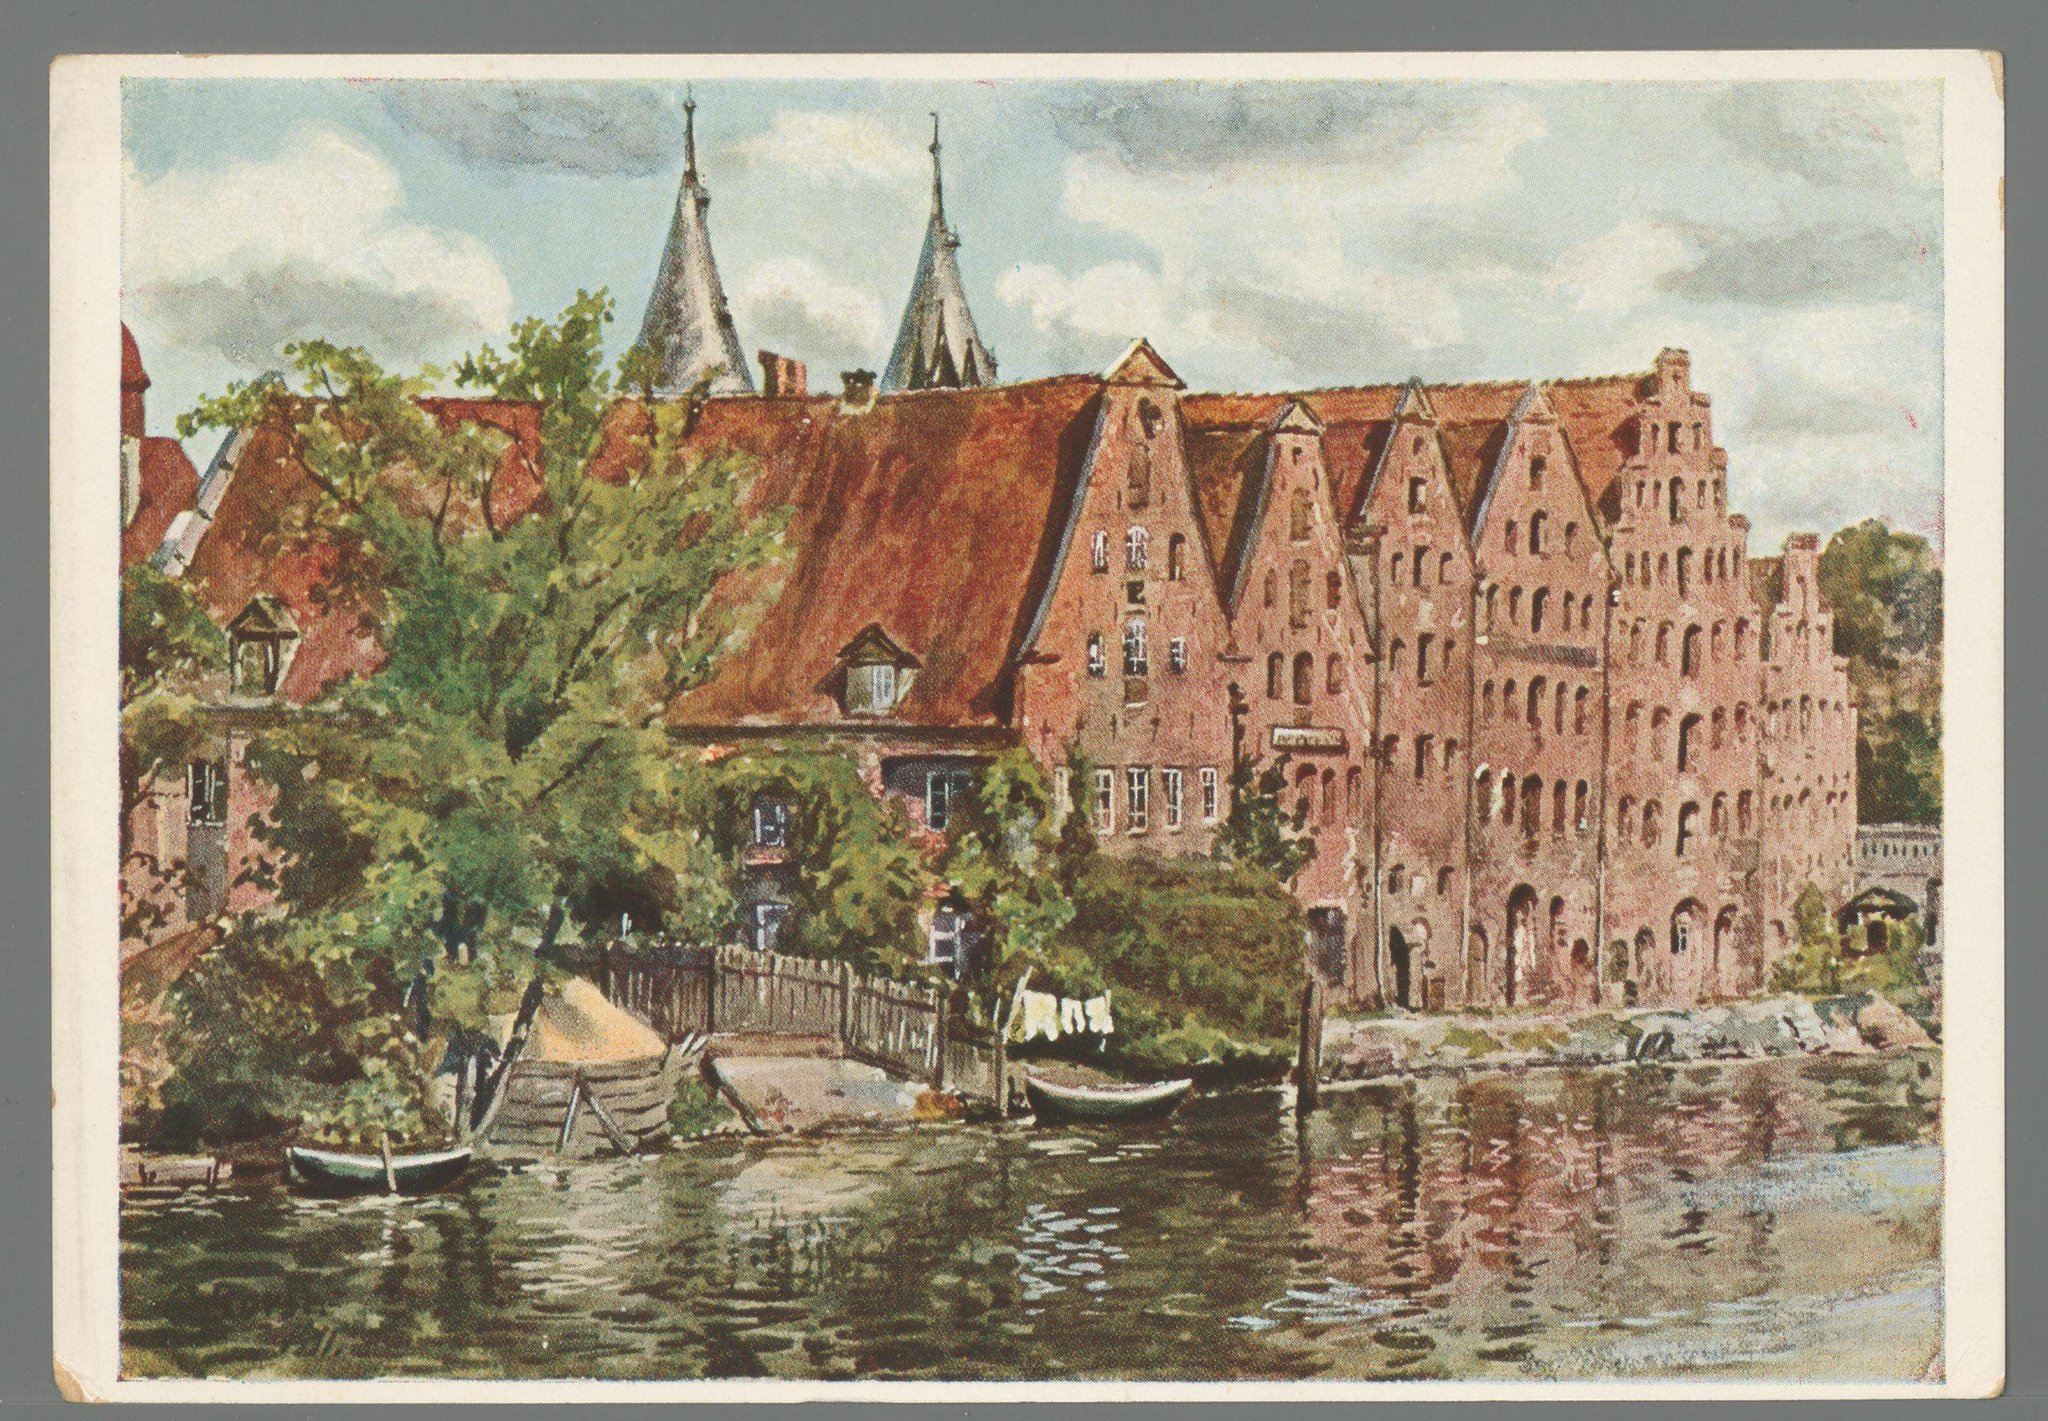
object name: photomechanical print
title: Lübeck. Alte Salzspeicher an der Trave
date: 1911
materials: cardboard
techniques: color autotype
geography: lübeck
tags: canals, waters (in city), street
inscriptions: date